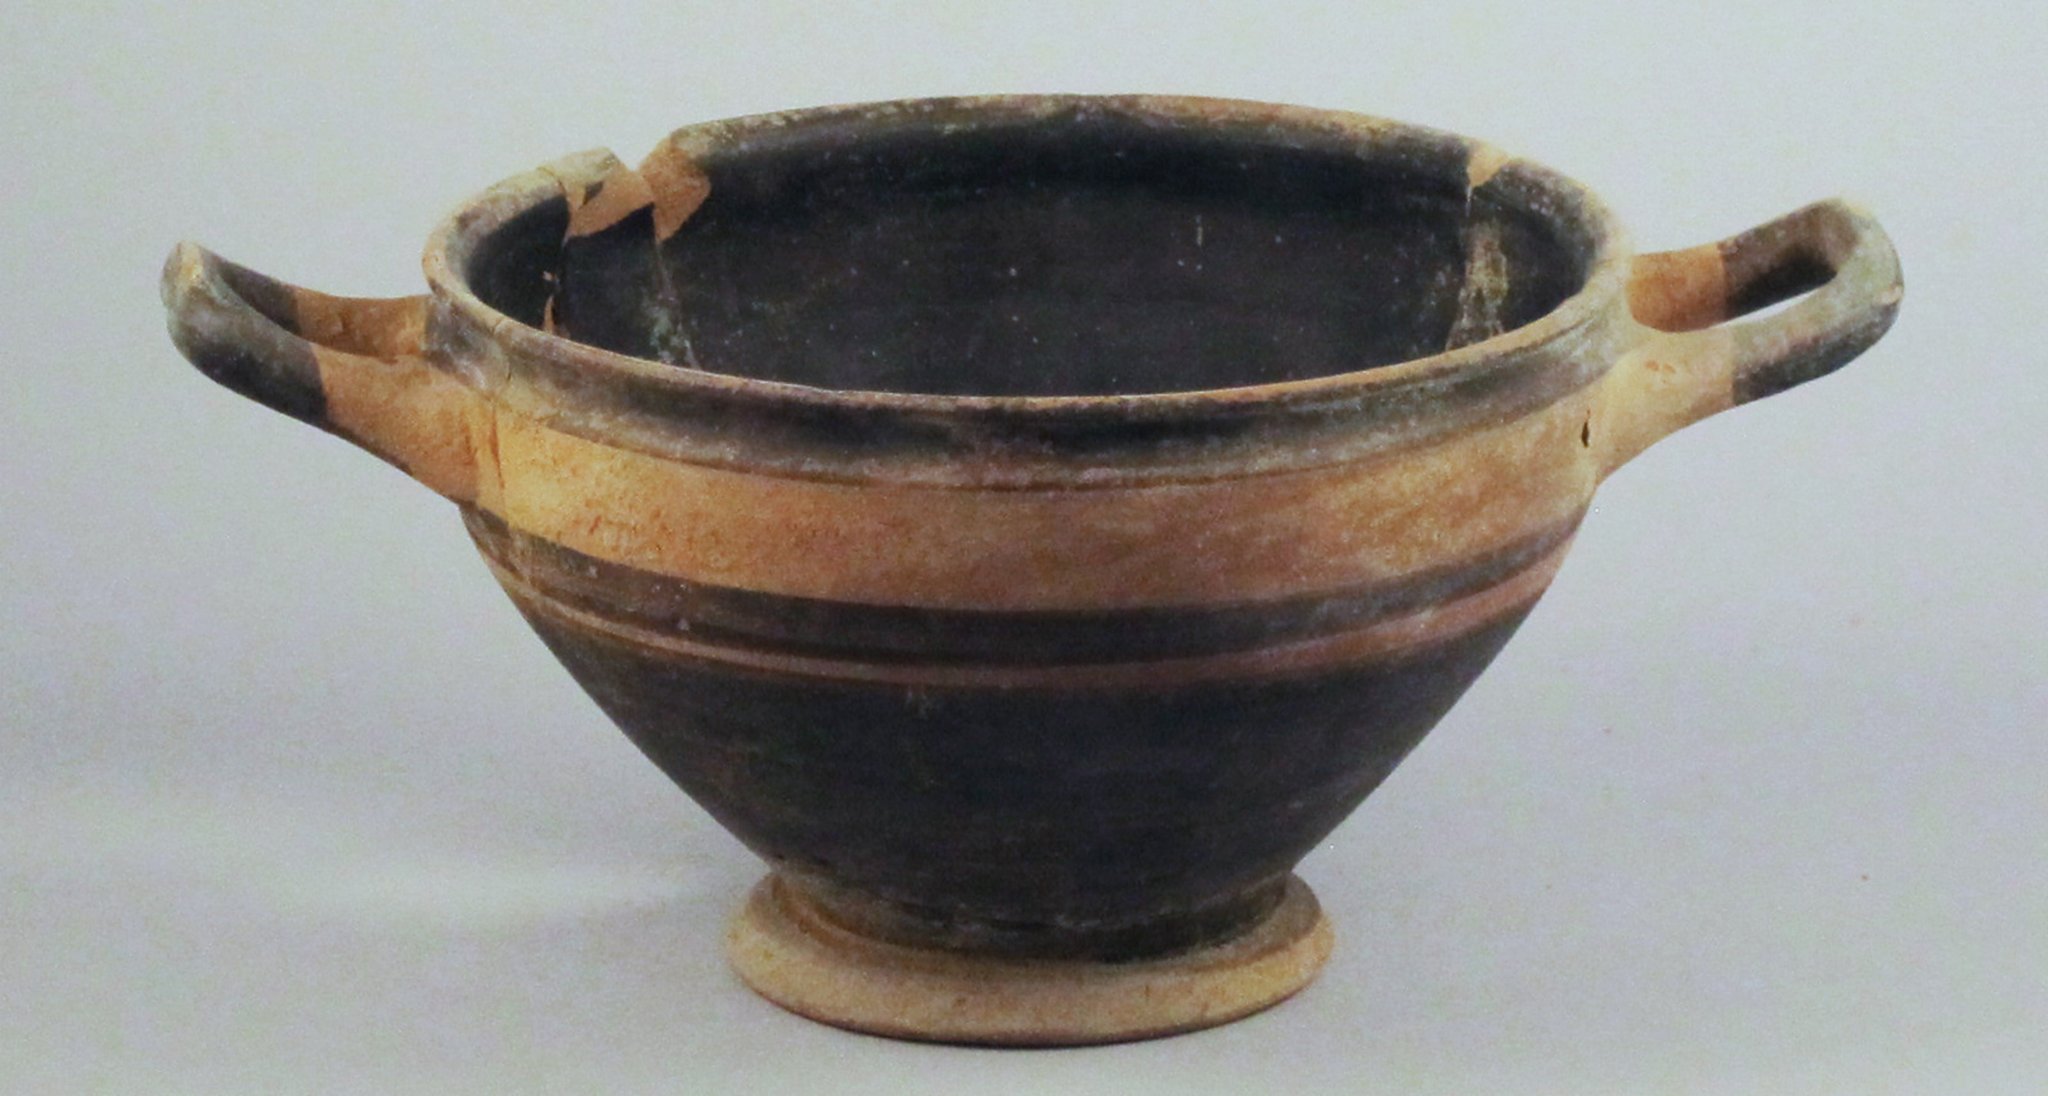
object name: skyphos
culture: east greek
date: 900-30 BCE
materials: terracotta